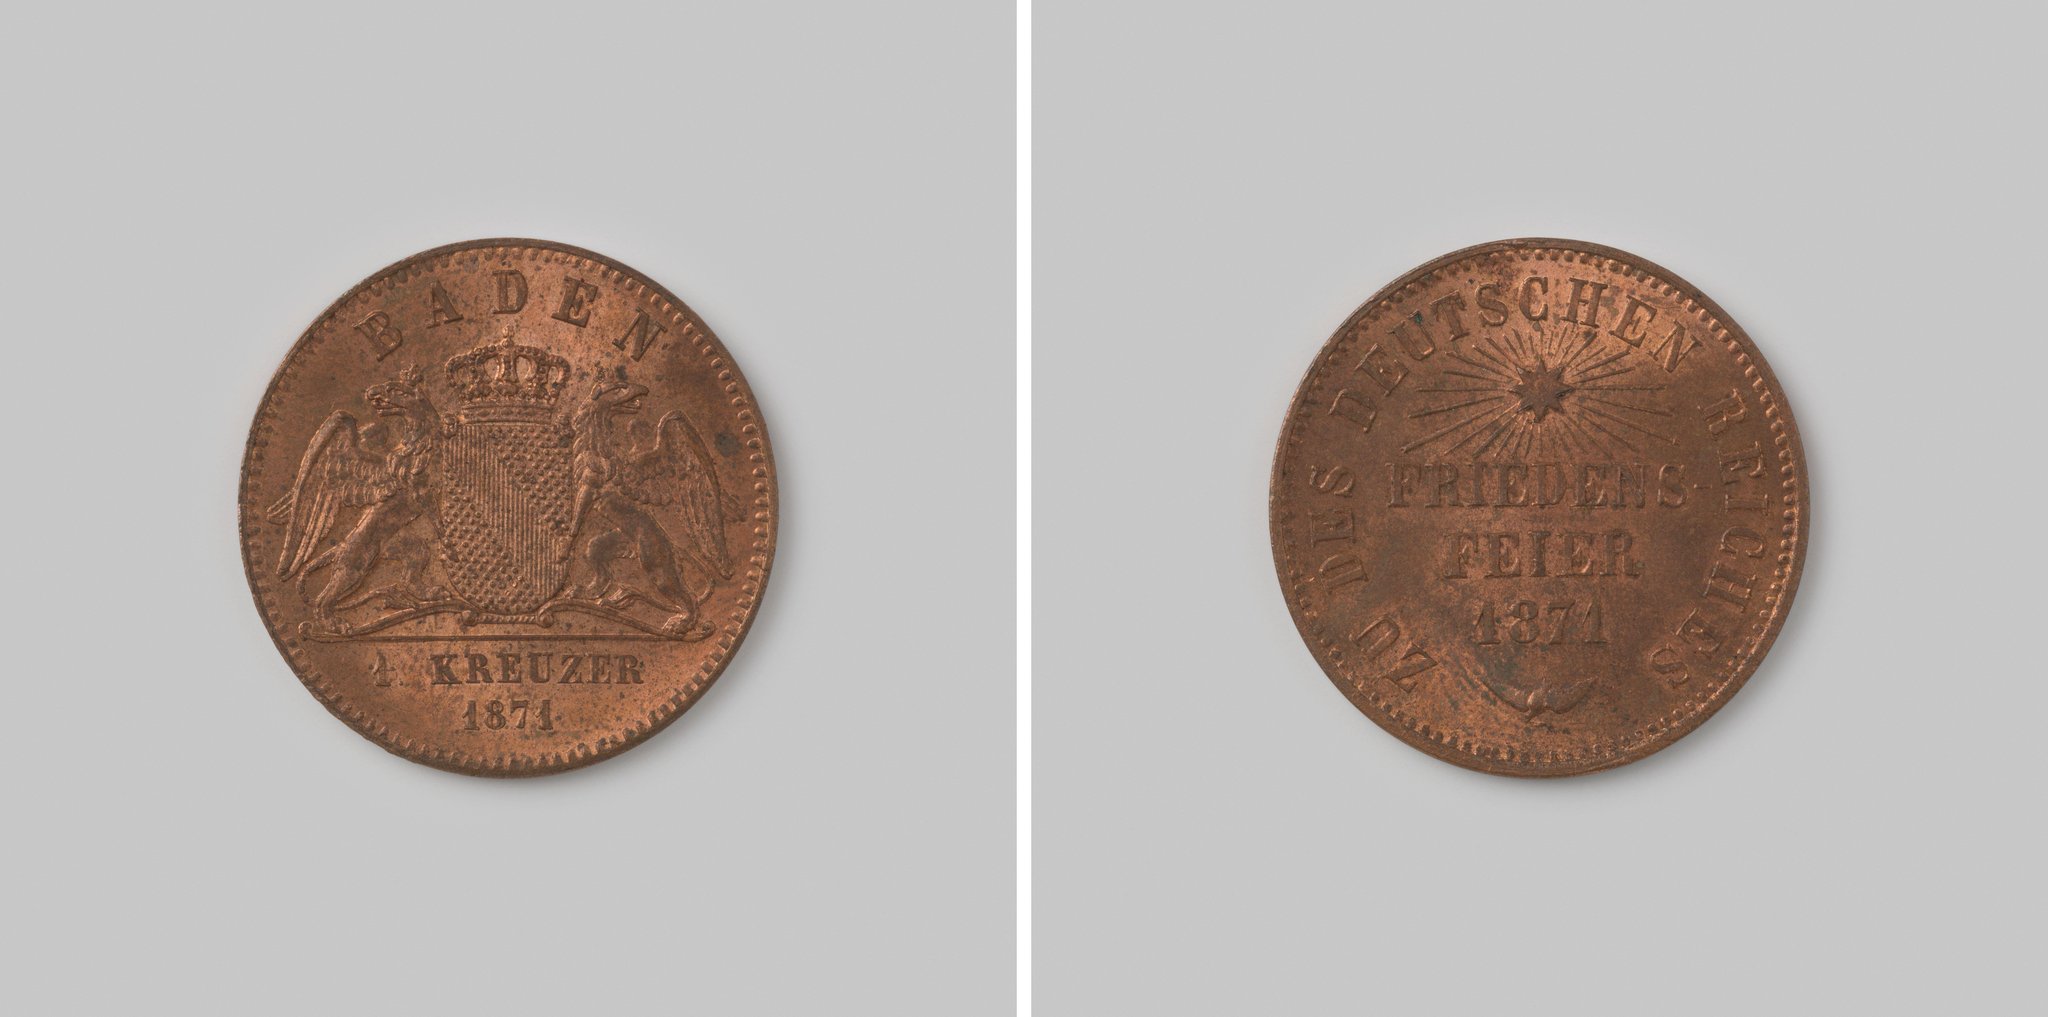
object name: coin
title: Gedachteniskreuzer uit het groothertogdom Baden van Friedrich, 1871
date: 1871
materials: copper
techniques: striking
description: Koperen munt. Voorzijde: door twee gekroonde griffioenen gehouden gekroond wapenschild. In afsnede waarde-aanduiding in een regel. Daaronder jaartal. Keerzijde: binnenn omschrift: ZU DES DEUTSCHEN REICHES stralende ster, waaronder opschrift in twee regels: FRIEDENS FEIER. Daaronder jaartal, waaronder vliegende duif. Gladde rand.